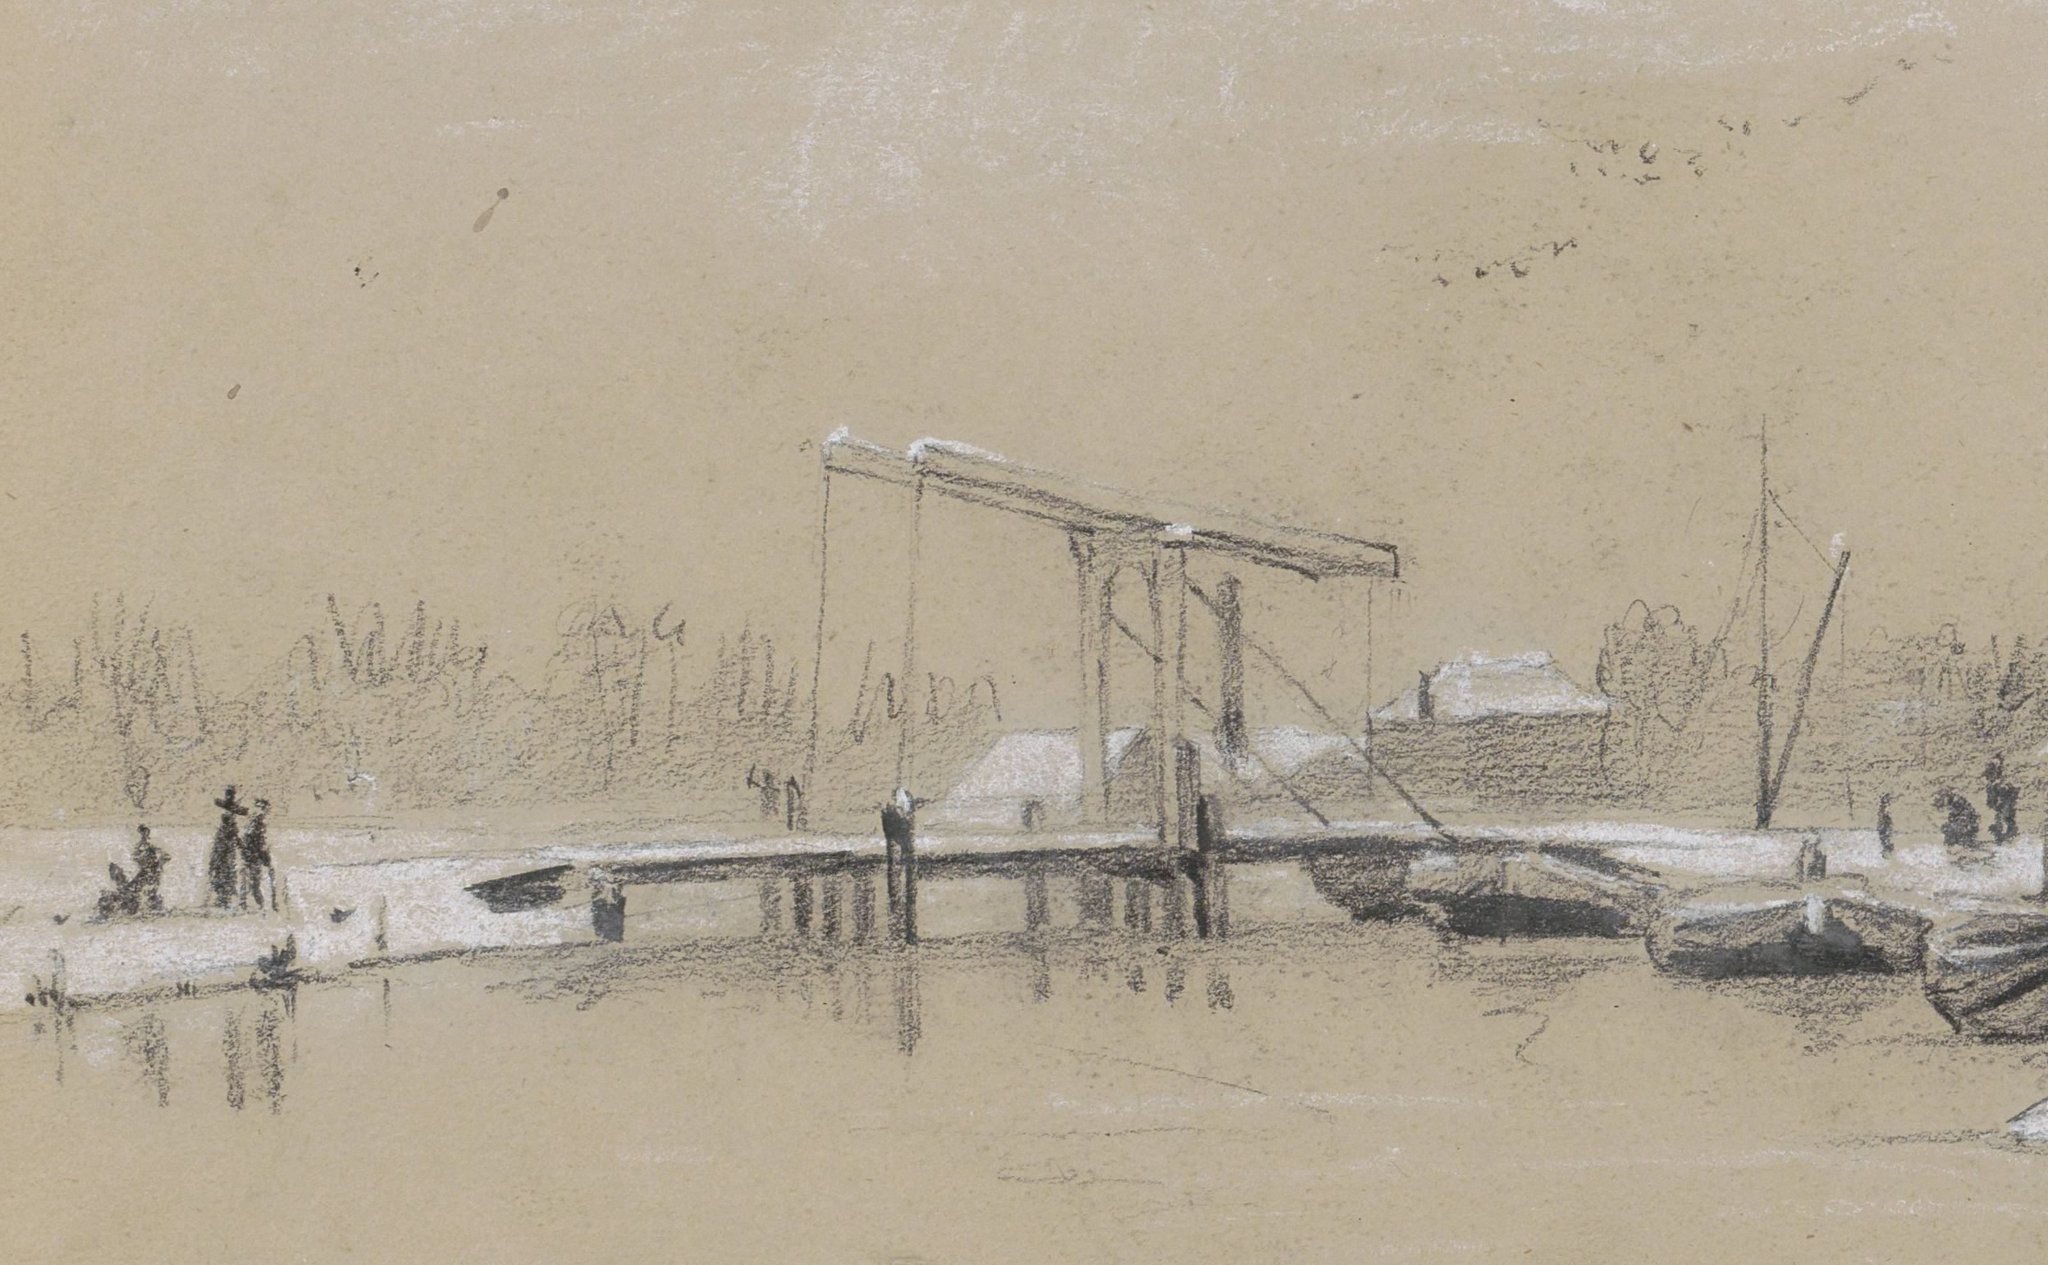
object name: sketchbook leaf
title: Ophaalbrug bij een stad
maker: willem cornelis rip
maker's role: draughtsman, painter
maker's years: 1856-1922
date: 1874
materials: chalk, paper, pencil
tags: city-view, and landscape with man-made constructions, bridge, windmill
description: Op de voorgrond roeiboten langs een steiger. Op de achtergrond de contouren van een stad met een molen. Blad 40 verso uit een schetsboek met 47 bladen.